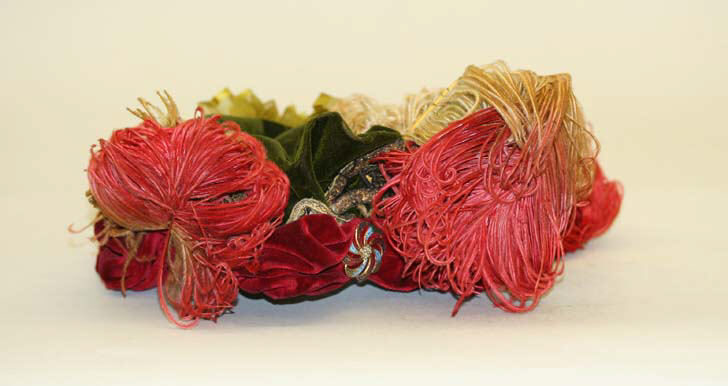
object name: bonnet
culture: american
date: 1890-1895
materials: silk